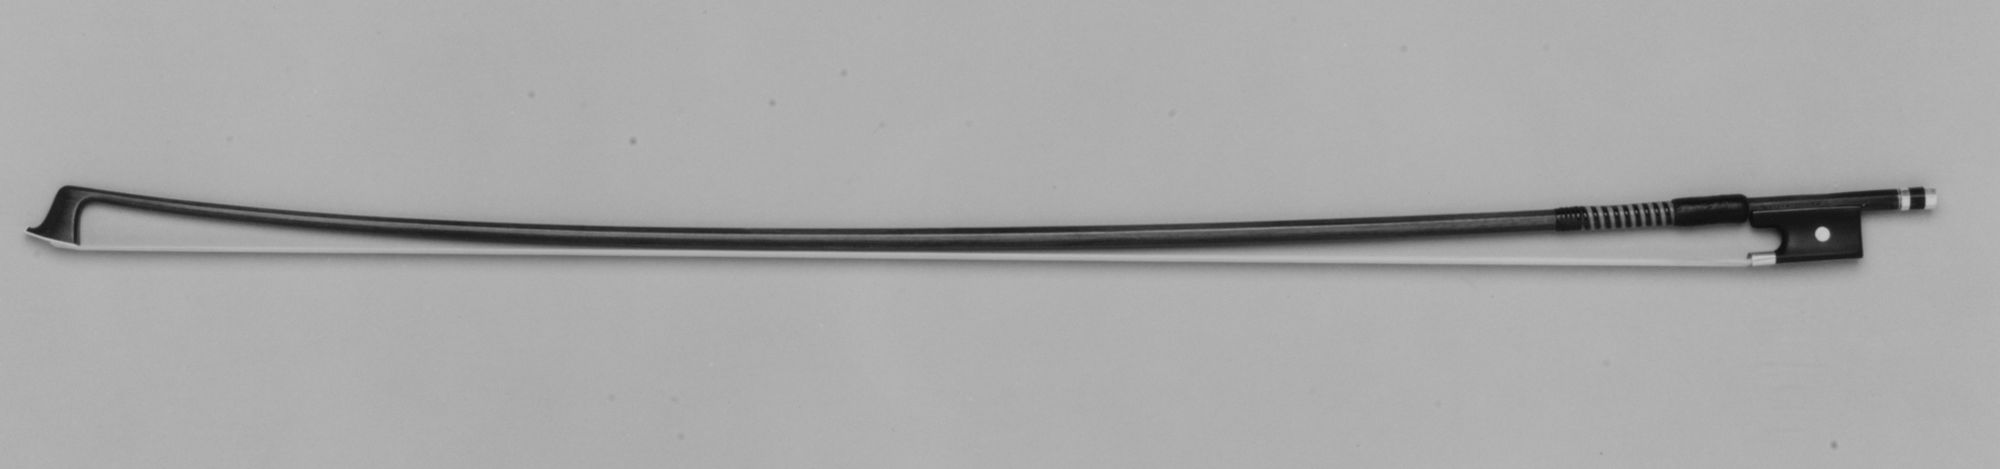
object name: bow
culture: french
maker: francois nicolas voirin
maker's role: maker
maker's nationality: french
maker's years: 1833-1885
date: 1860-1880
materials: wood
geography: france